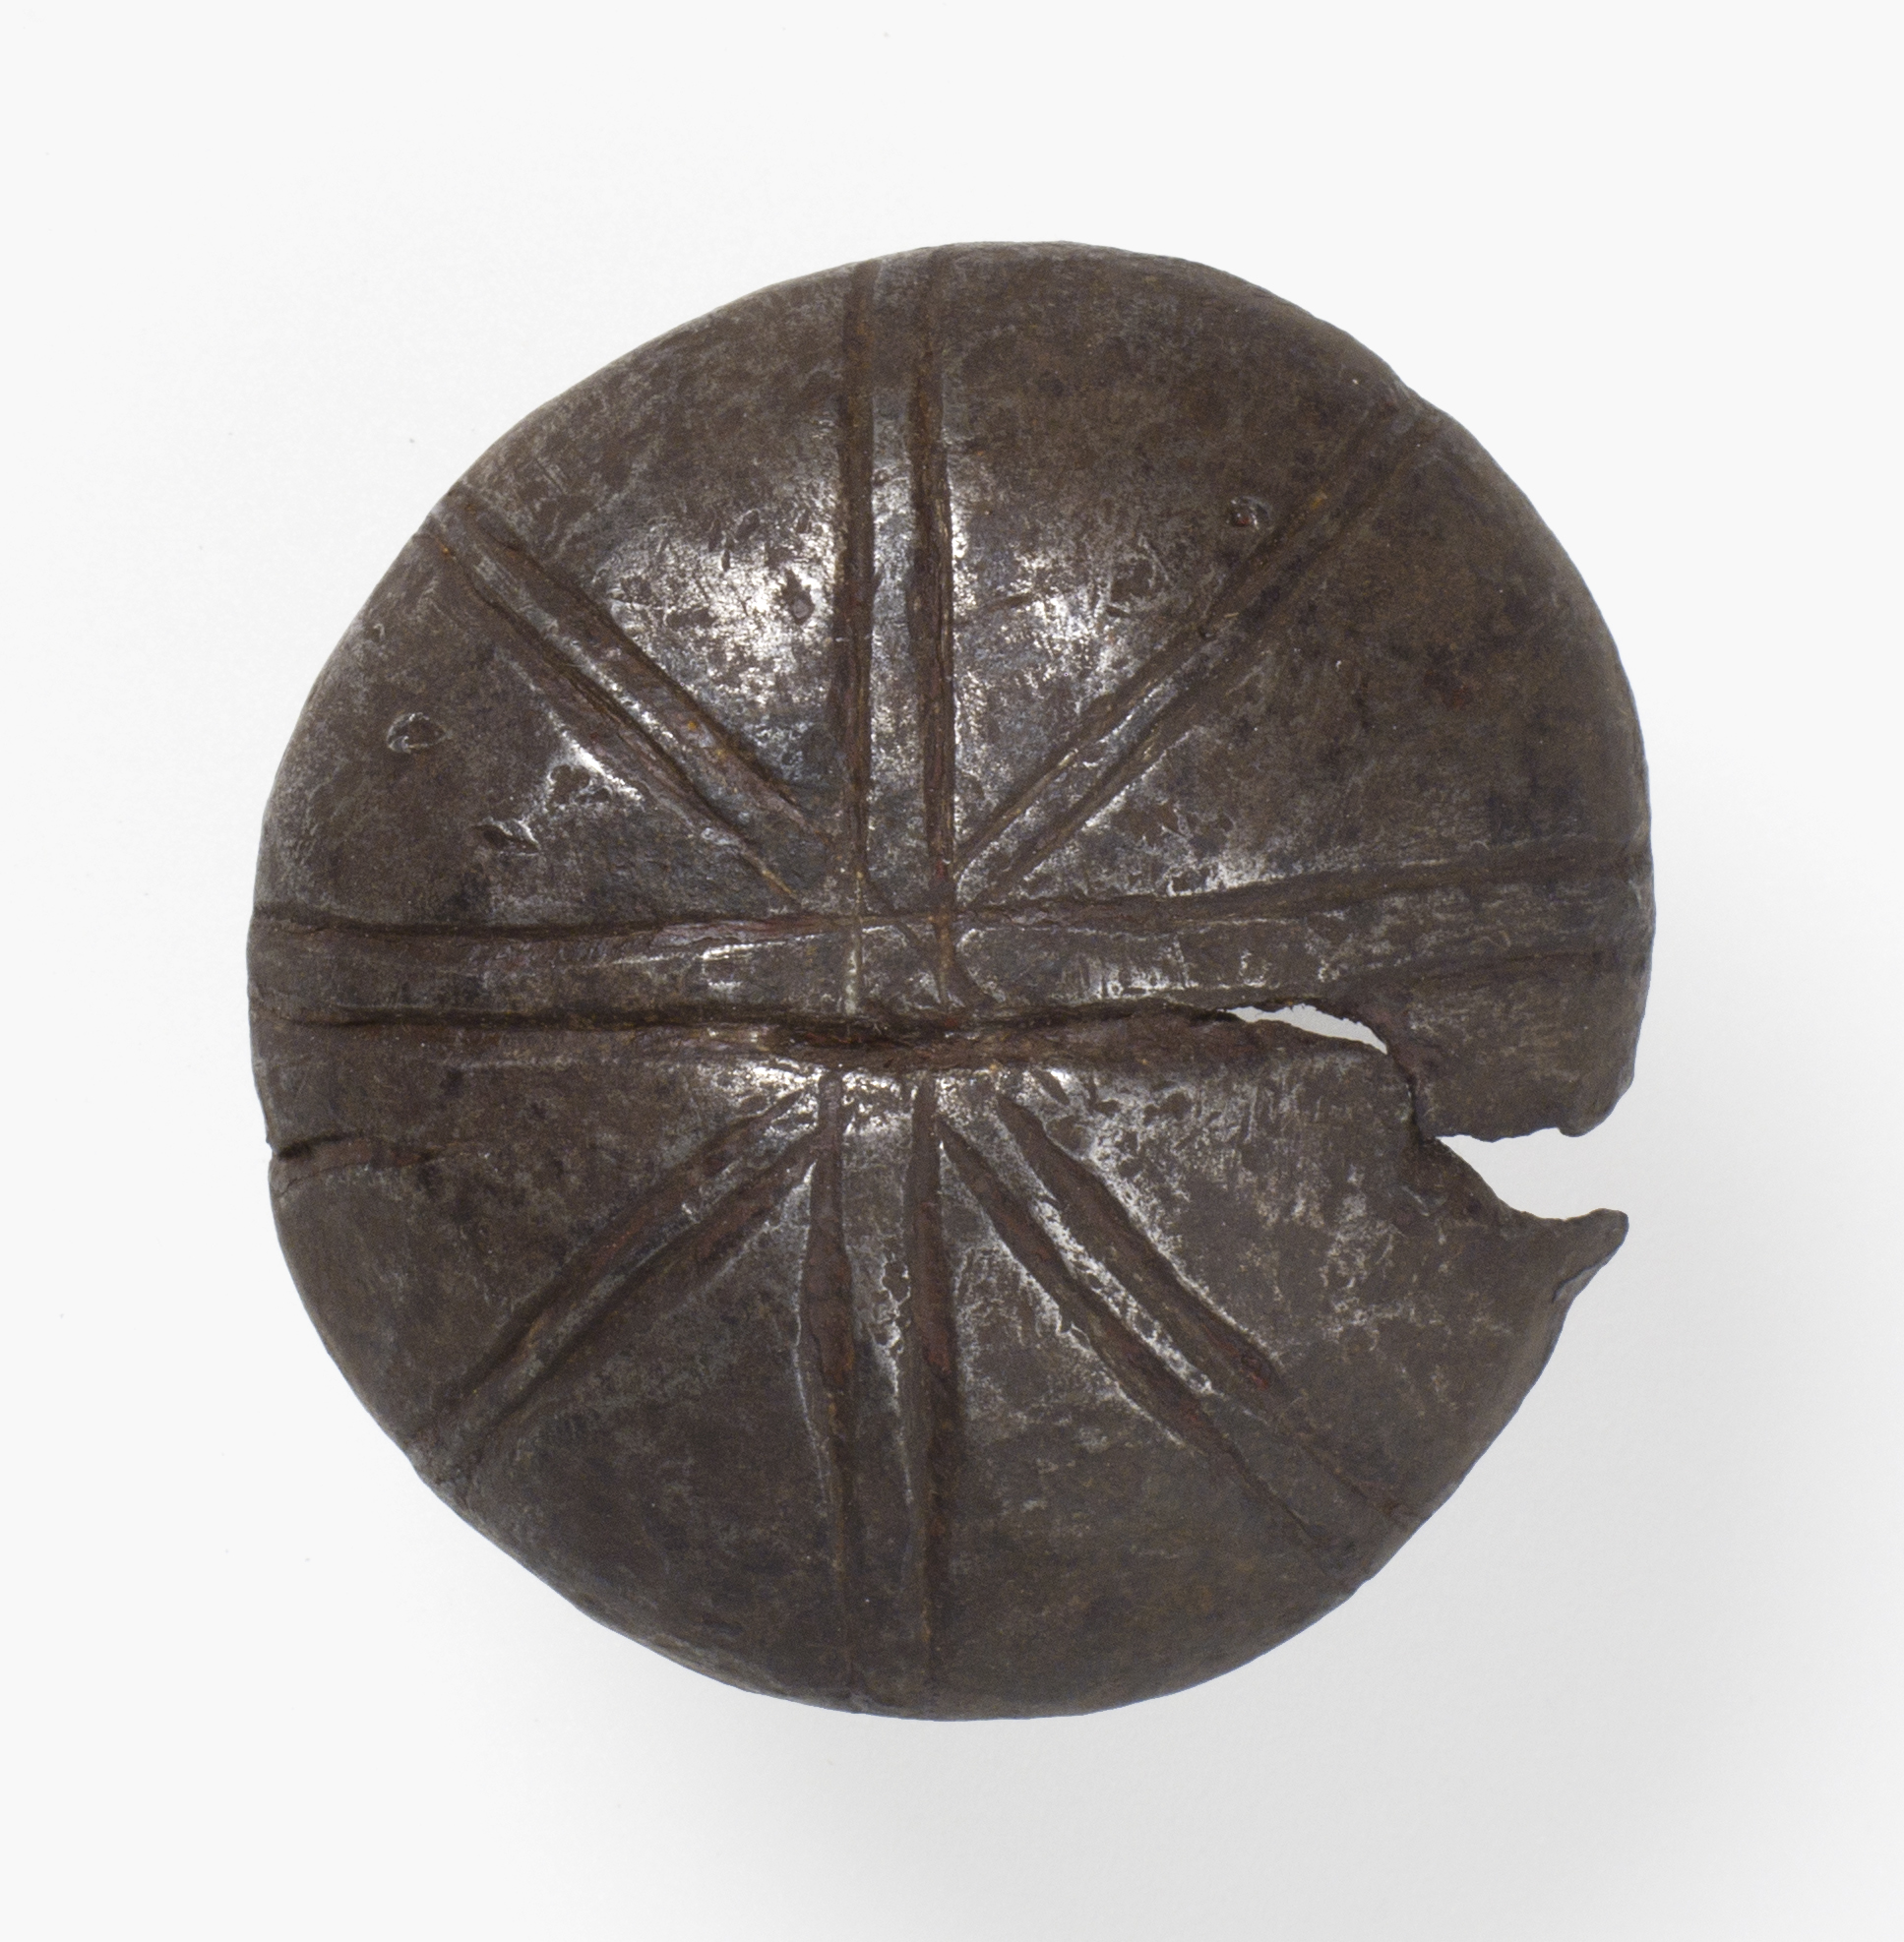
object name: nail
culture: european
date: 1401-1600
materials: iron